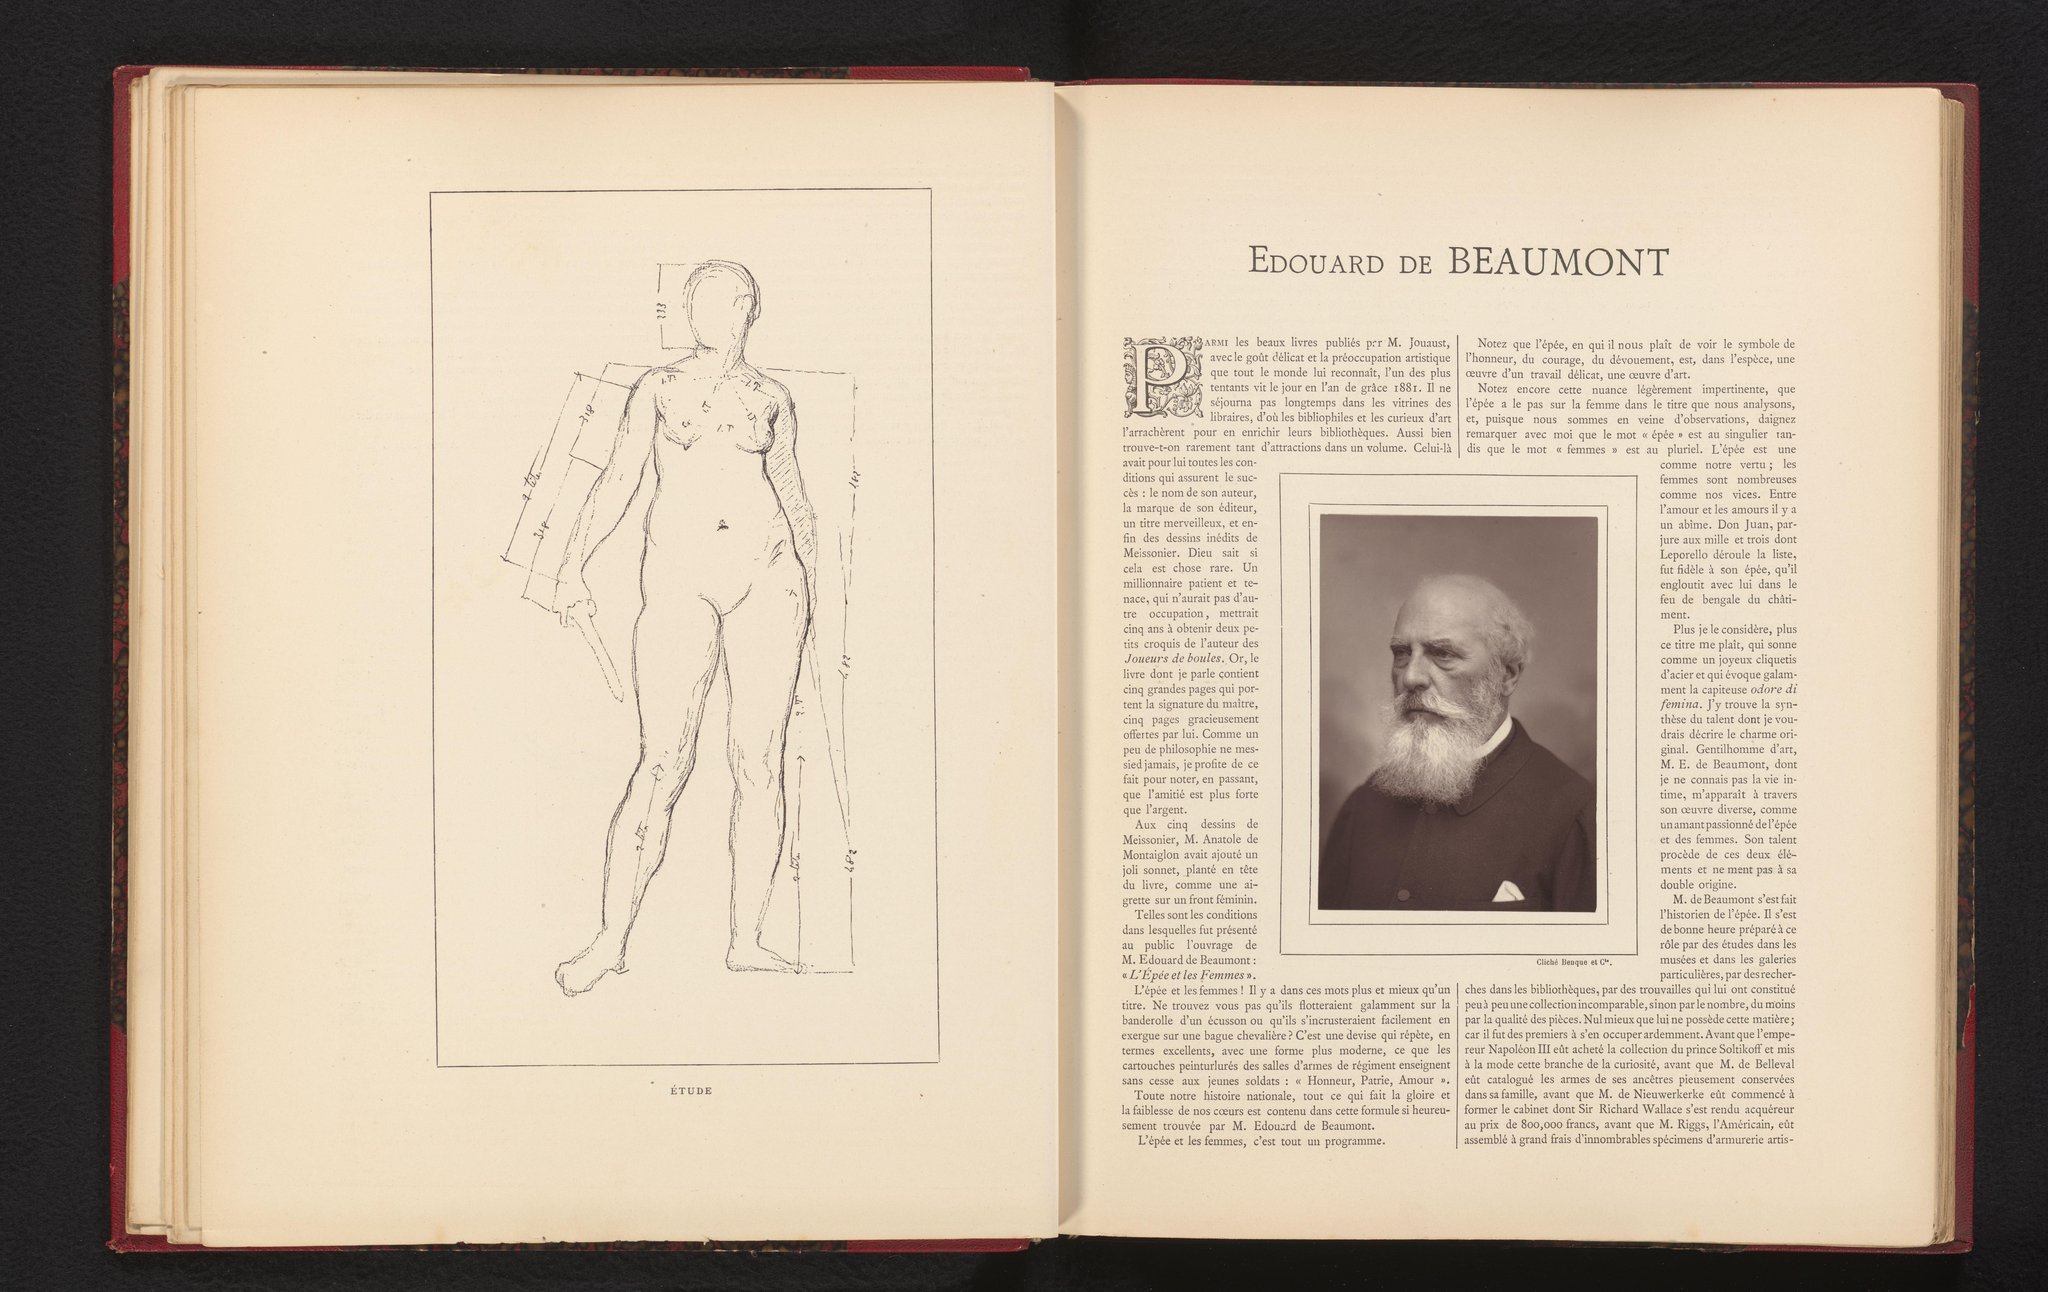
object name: page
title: Portret van Edouard de Beaumont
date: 1879-1884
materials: paper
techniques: woodburytype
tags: painter, draughtsman, edouard de beaumont, historical persons